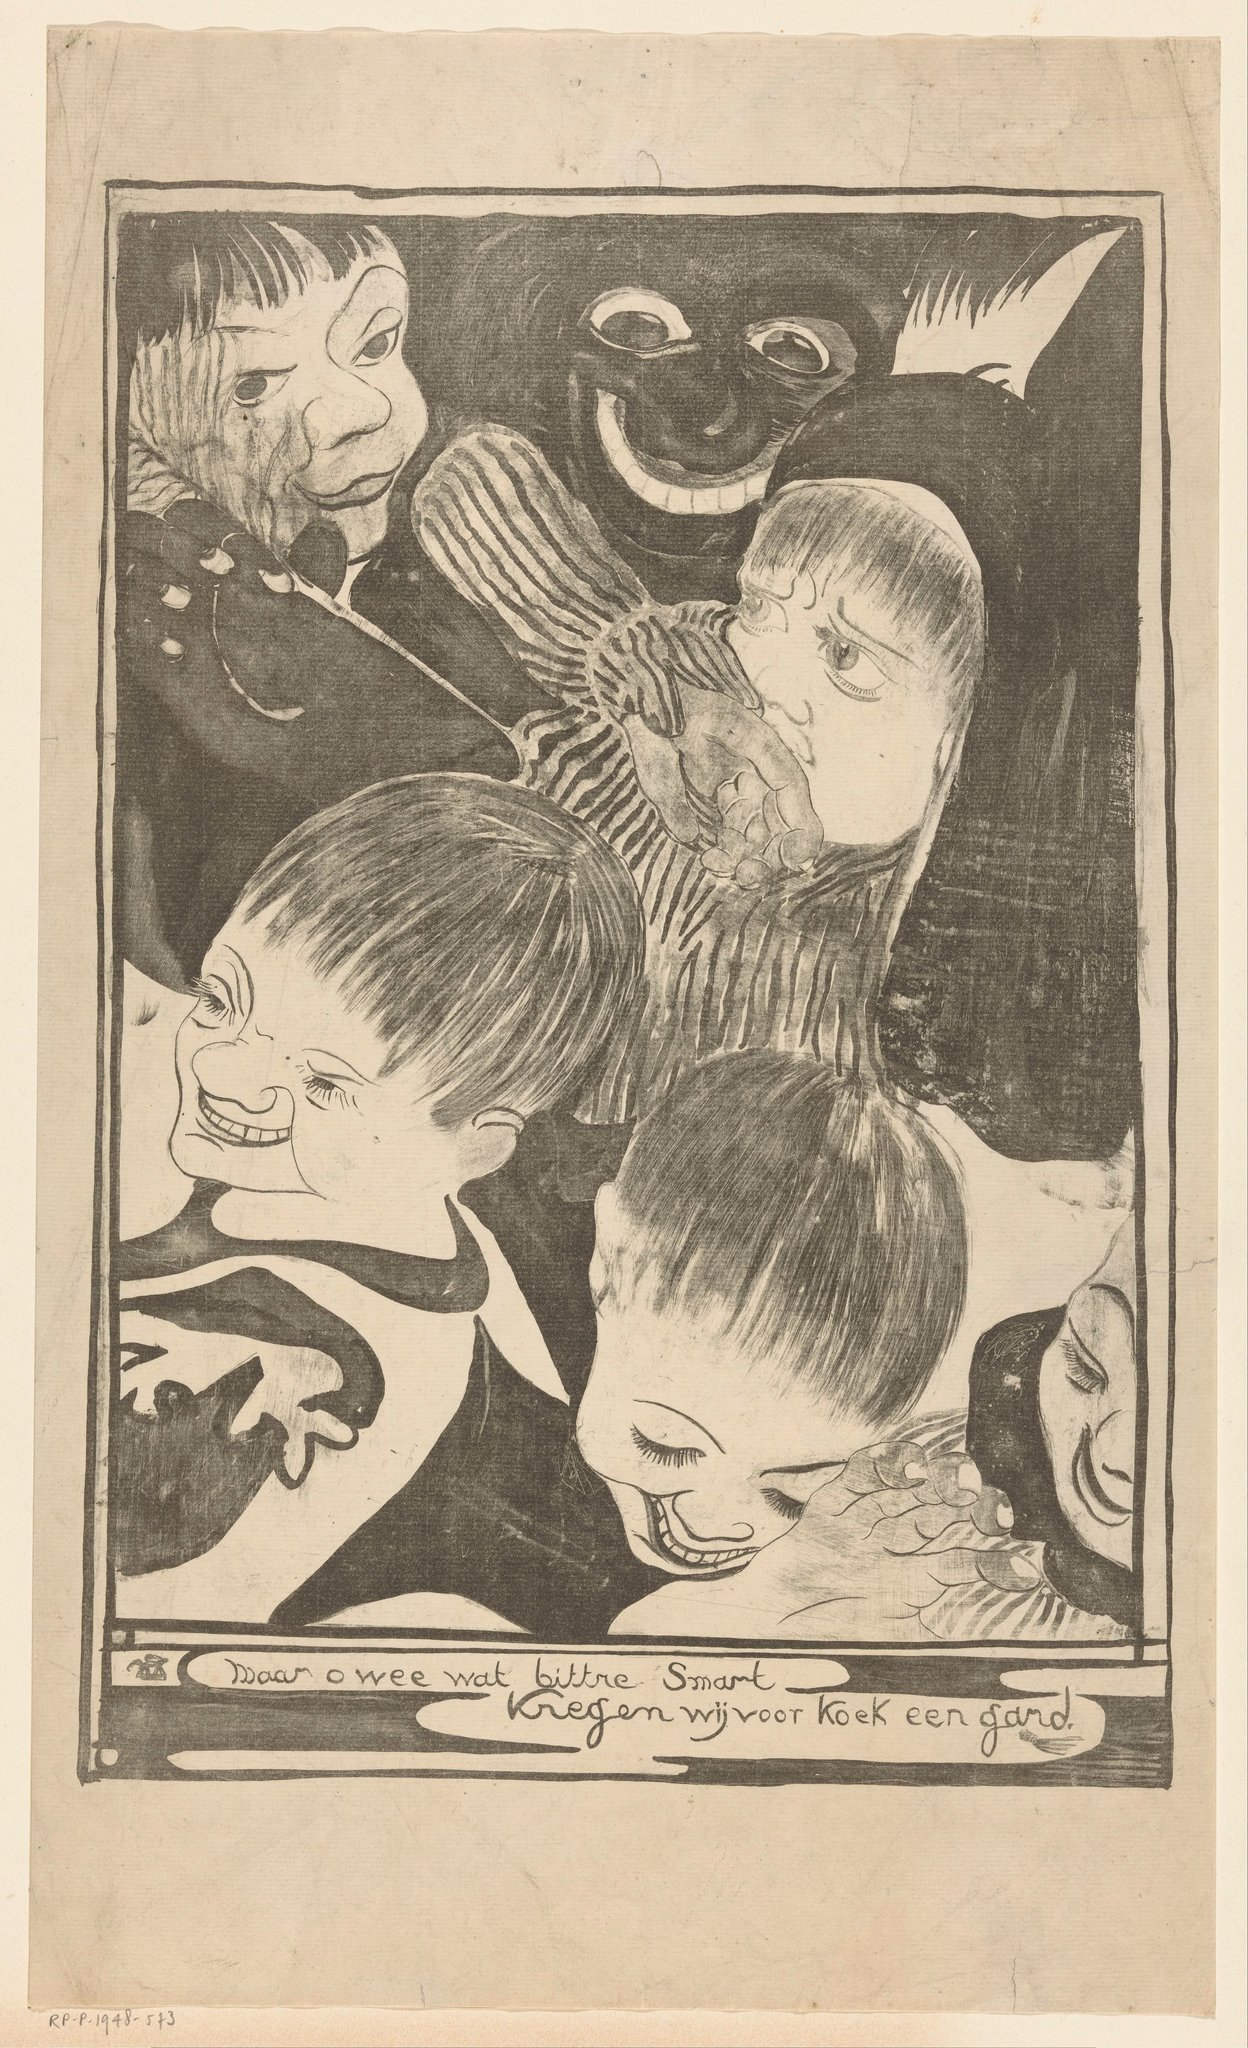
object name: poem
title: Kinderhoofden en grijnzend gezicht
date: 1895-1896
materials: paper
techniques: lithograph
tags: child, festivities on st. nicholas (eve) (december 5)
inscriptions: collector's mark: Lugt 2228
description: Vijf lachende en verschrikt kijkende kinderhoofden. Bovenaan een donker grijnzend gezicht, mogelijk een masker of Zwarte Piet. Onderaan het sinterklaasvers: 'Maar o wee wat bittre smart, Kregen wij voor koek een gard'.